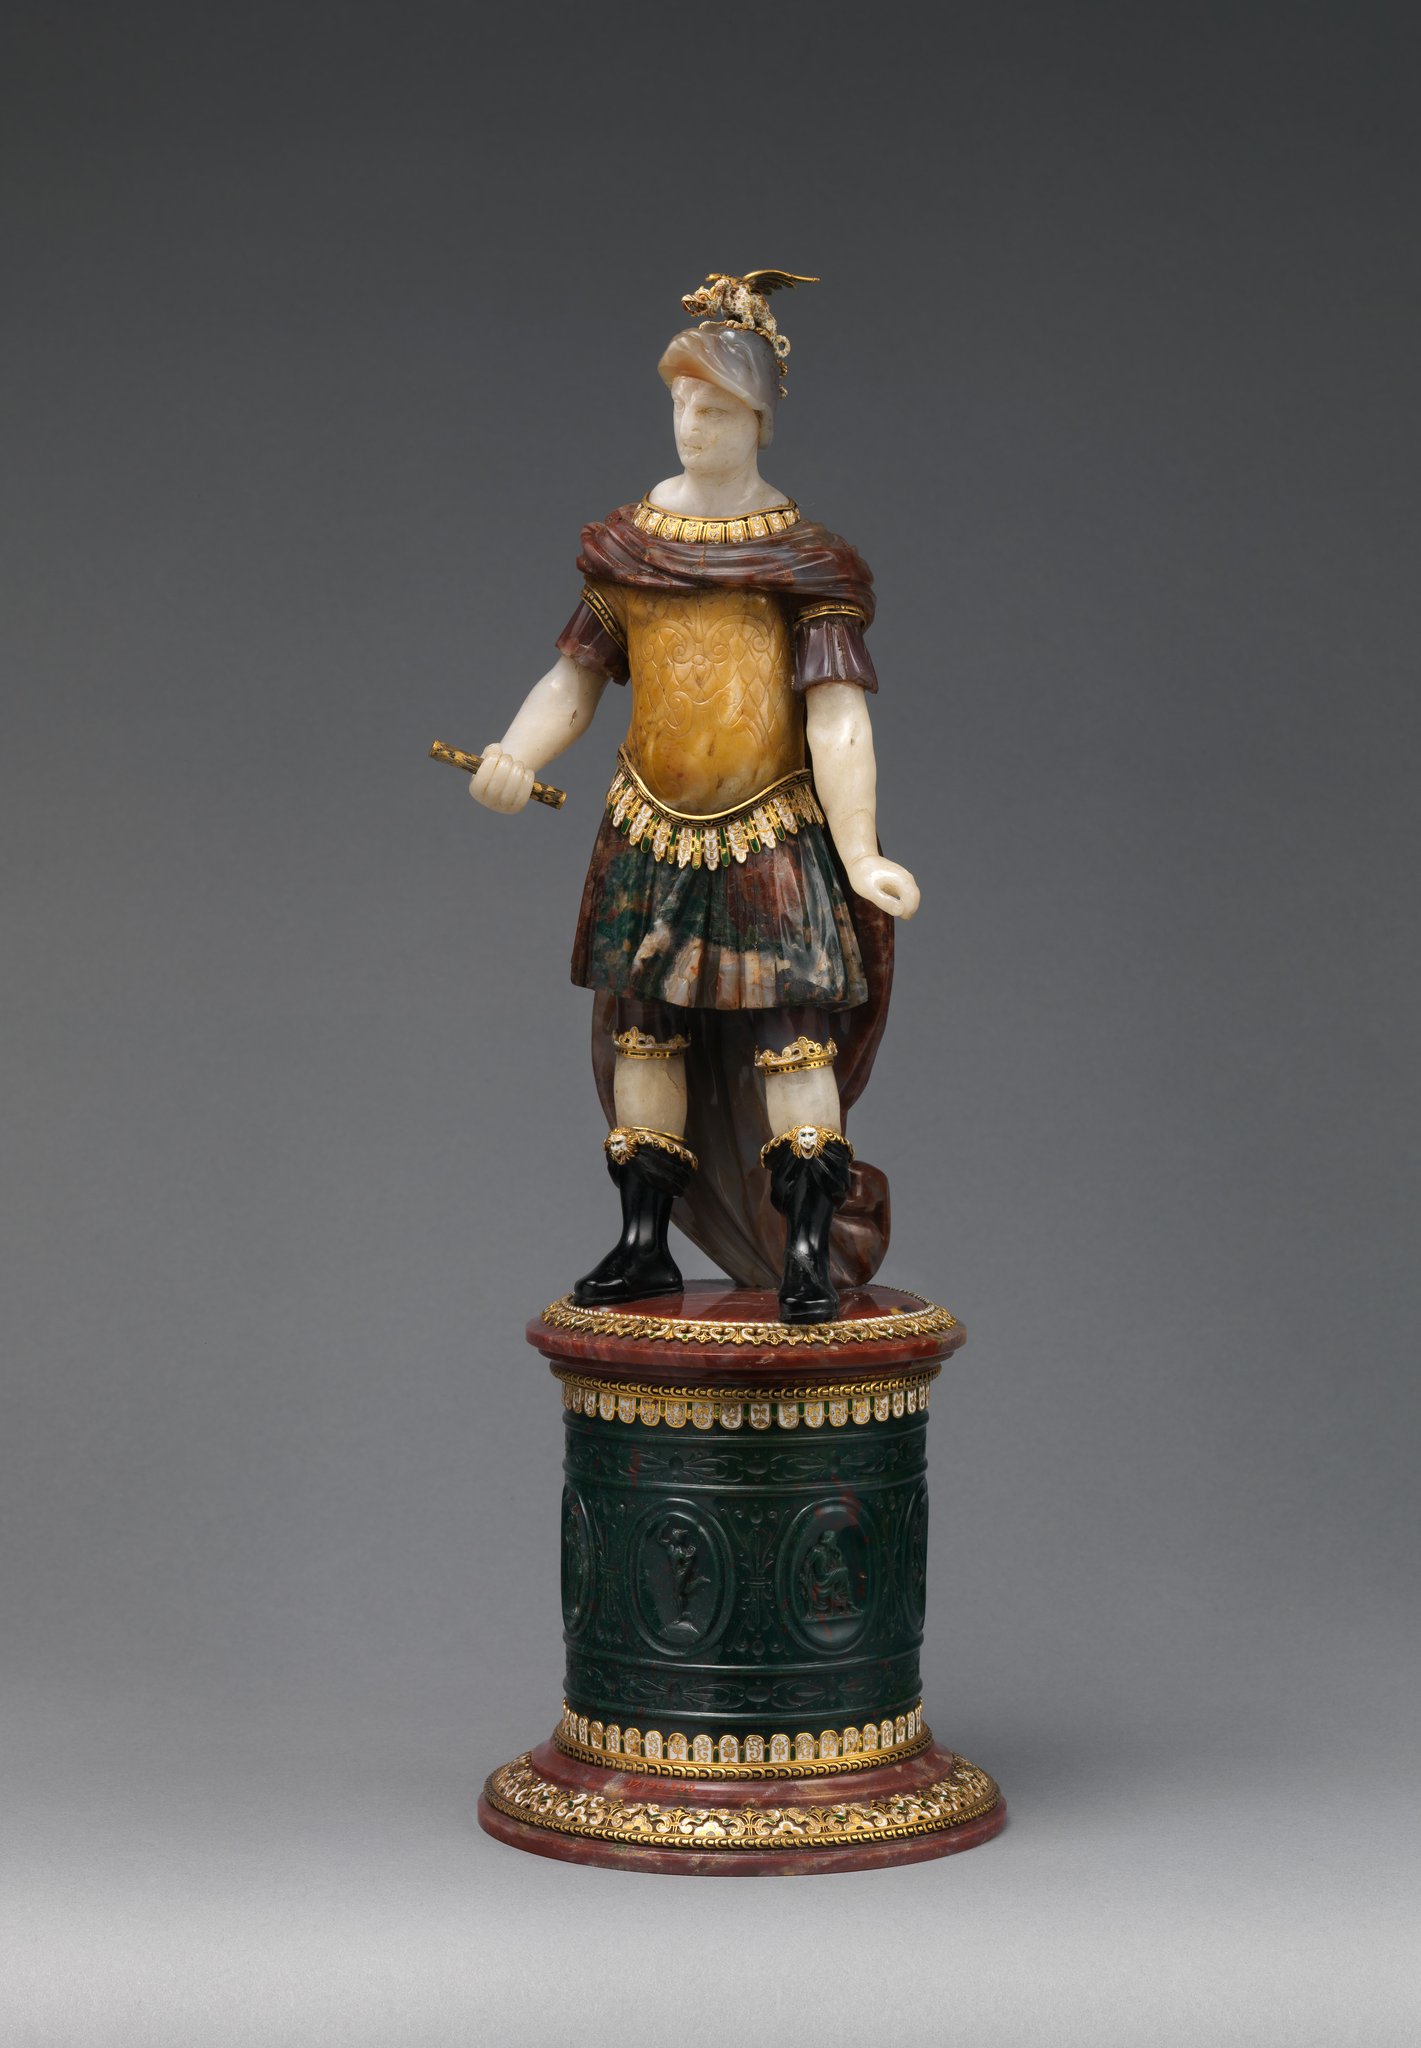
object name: statuette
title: Roman Emperor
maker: reinhold vasters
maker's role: artist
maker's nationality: german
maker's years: 1827-1909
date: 1801-1900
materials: enamel, gold, stone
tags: emperors,men,dragons